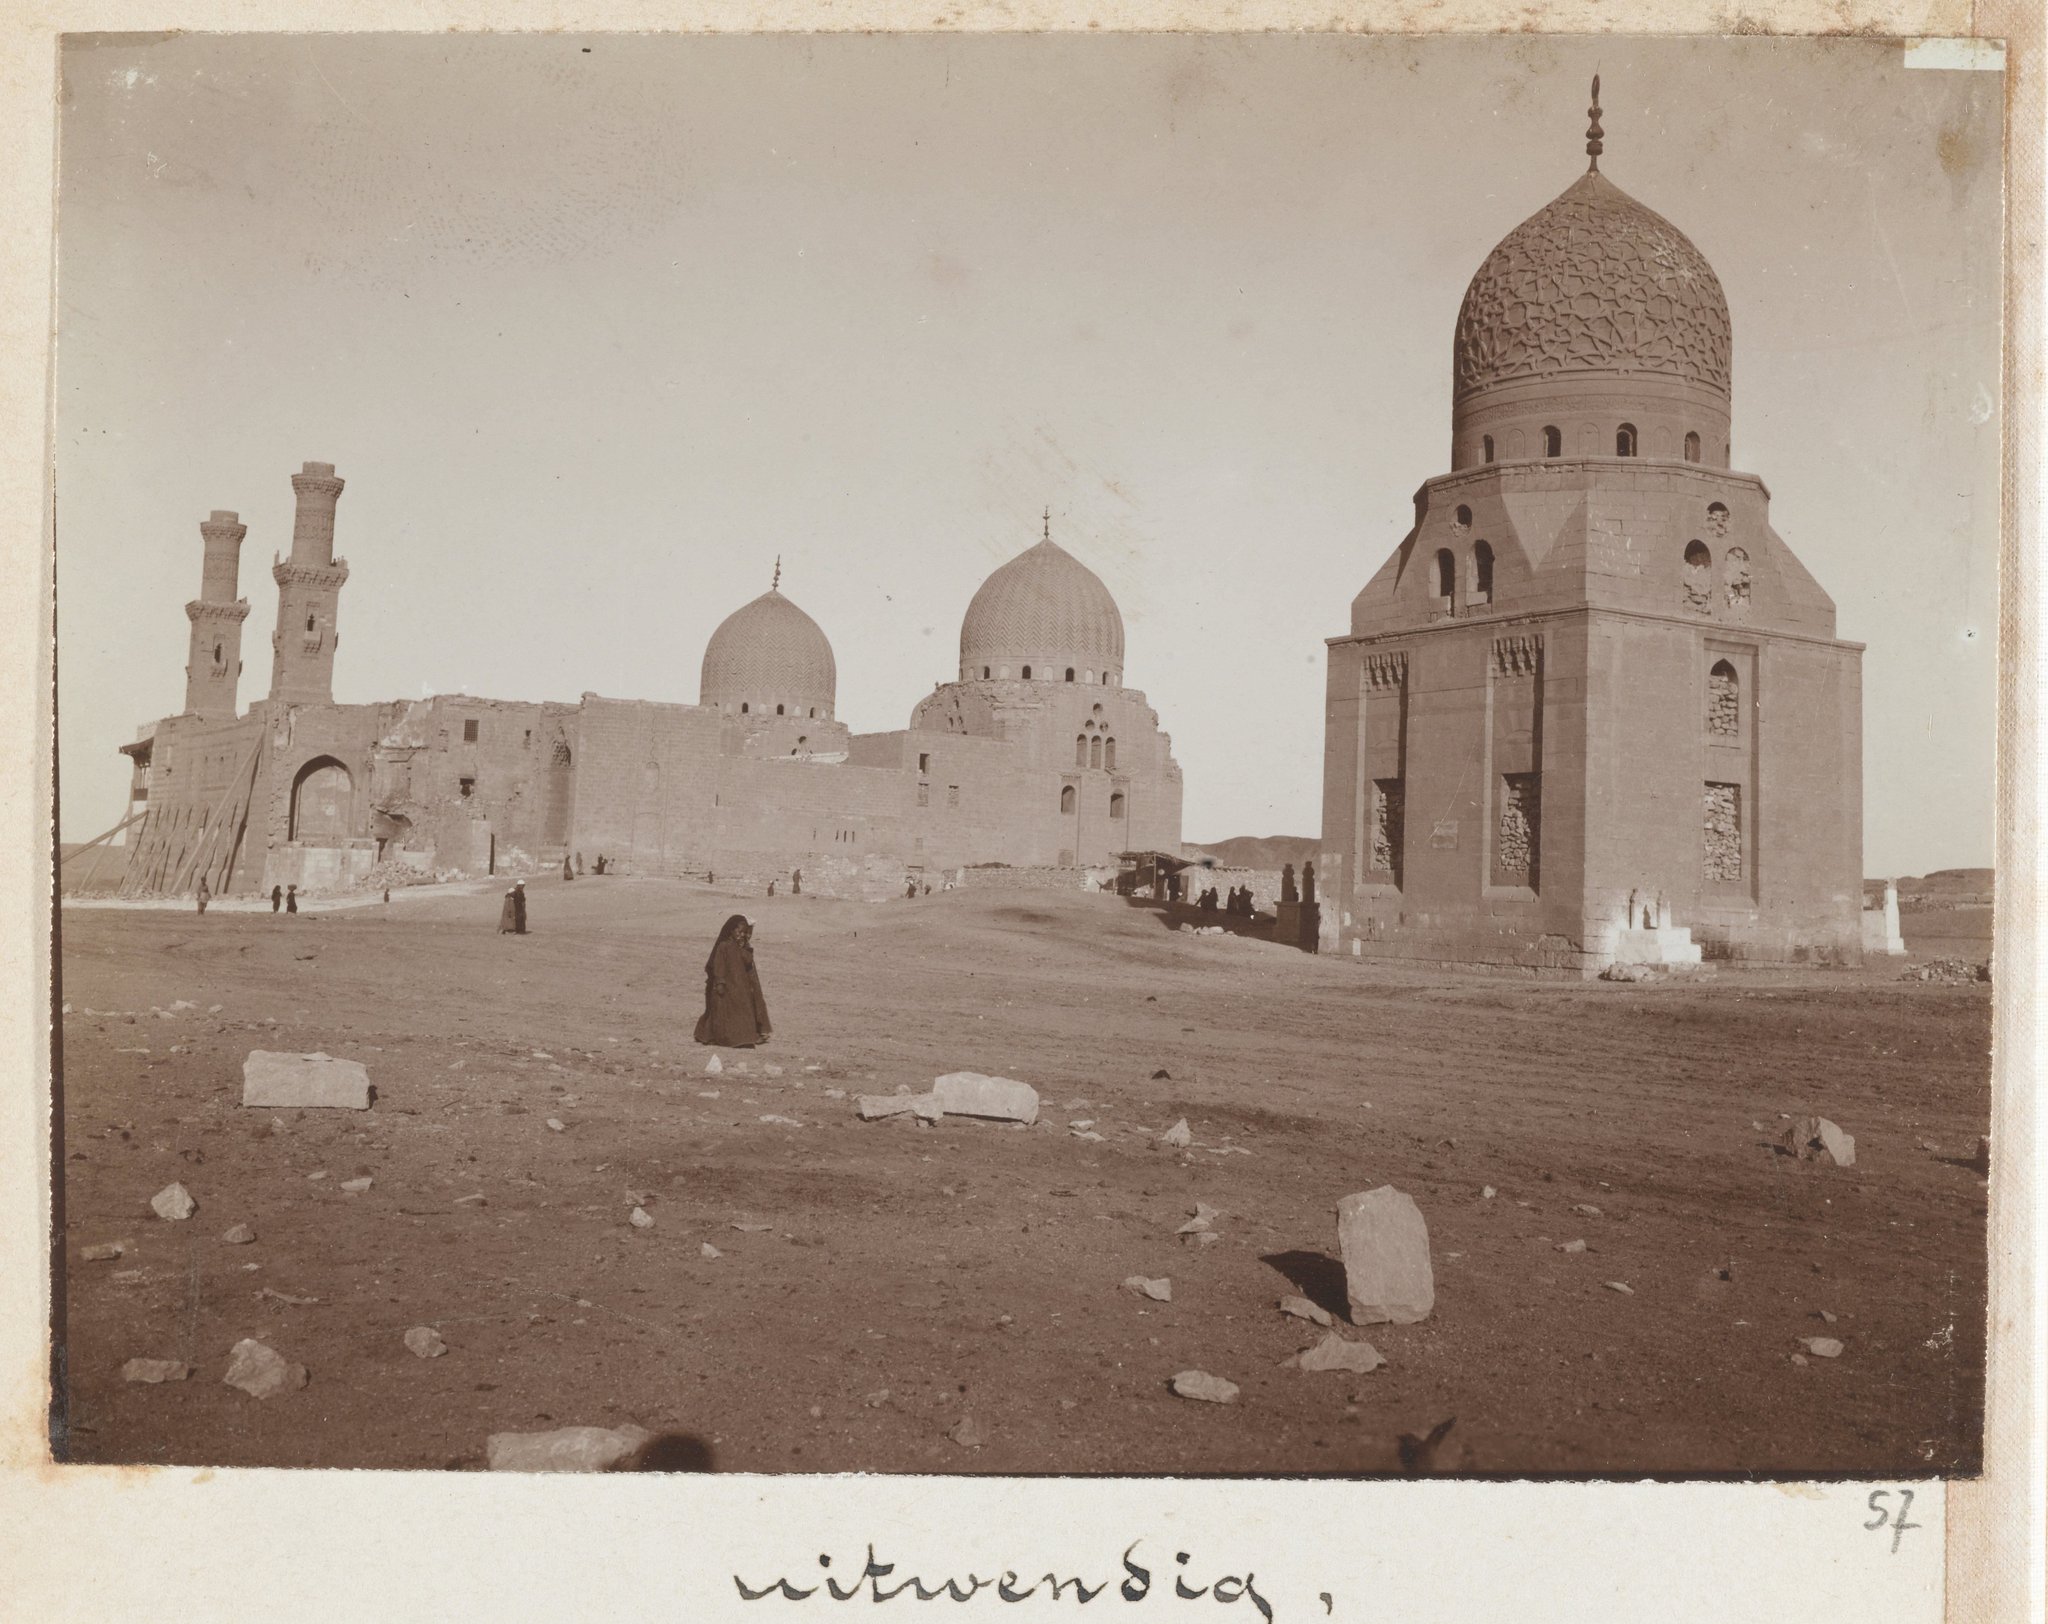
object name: page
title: Graven der Chalifen en Mammelukken, uitwendig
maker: johannes lodewijk heldring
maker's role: fotograaf, predikant, schrijver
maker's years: 1852-1923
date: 1898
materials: paper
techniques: collodion silver print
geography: cairo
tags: grave-building, monumental tomb